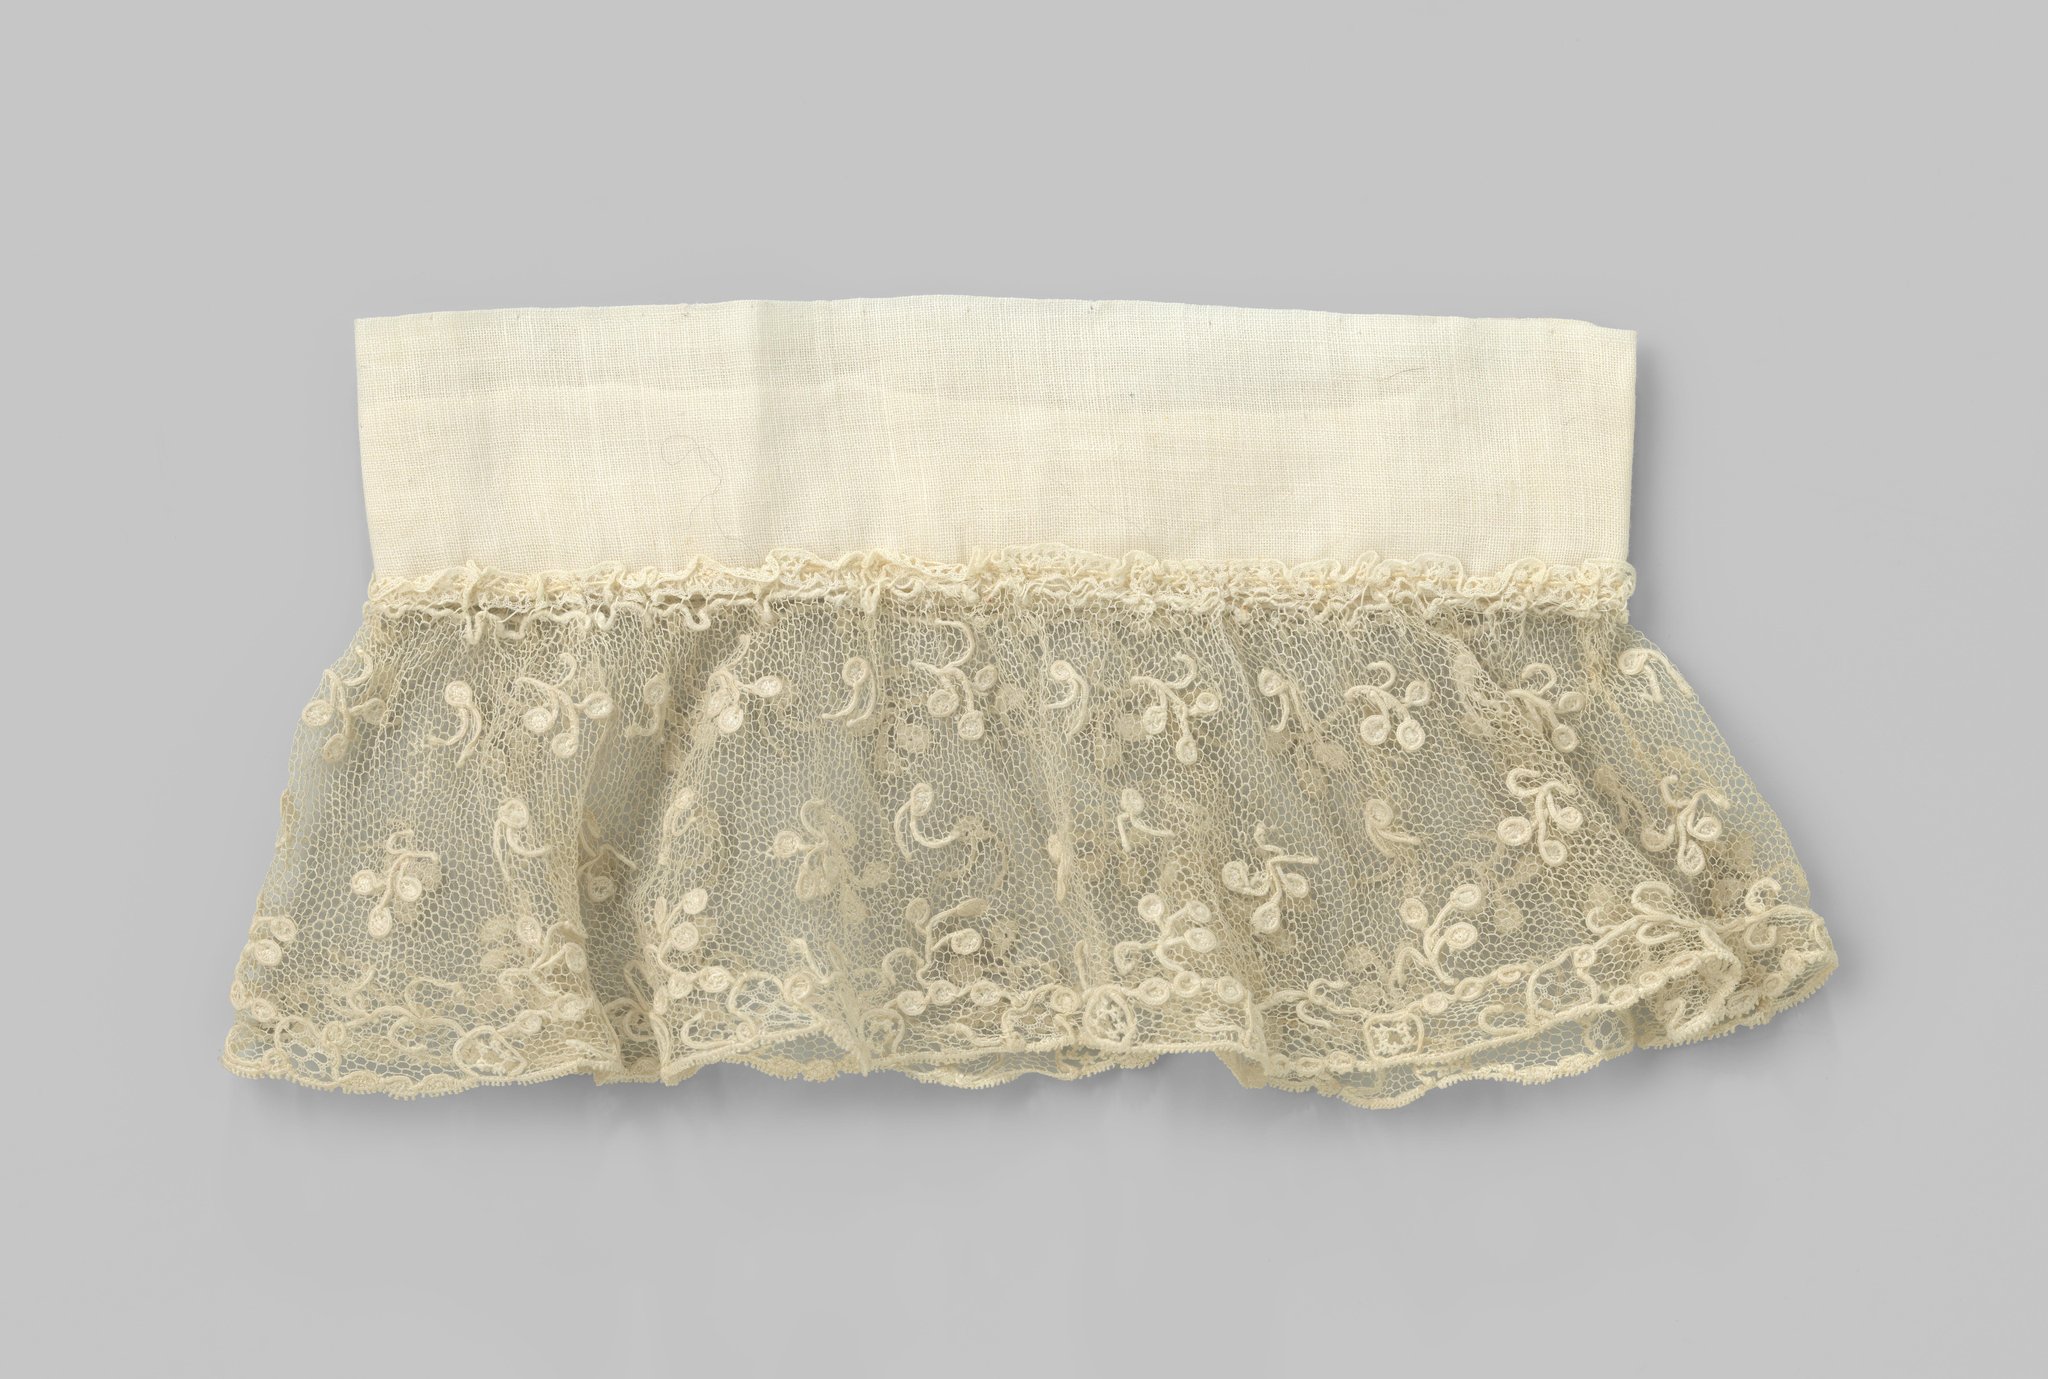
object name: sleeve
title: Mouw van witte tule met strooipatroon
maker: Anonymous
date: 1875-1910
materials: fiber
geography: europe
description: De tule is gerimpeld aan een witte strook gezet.